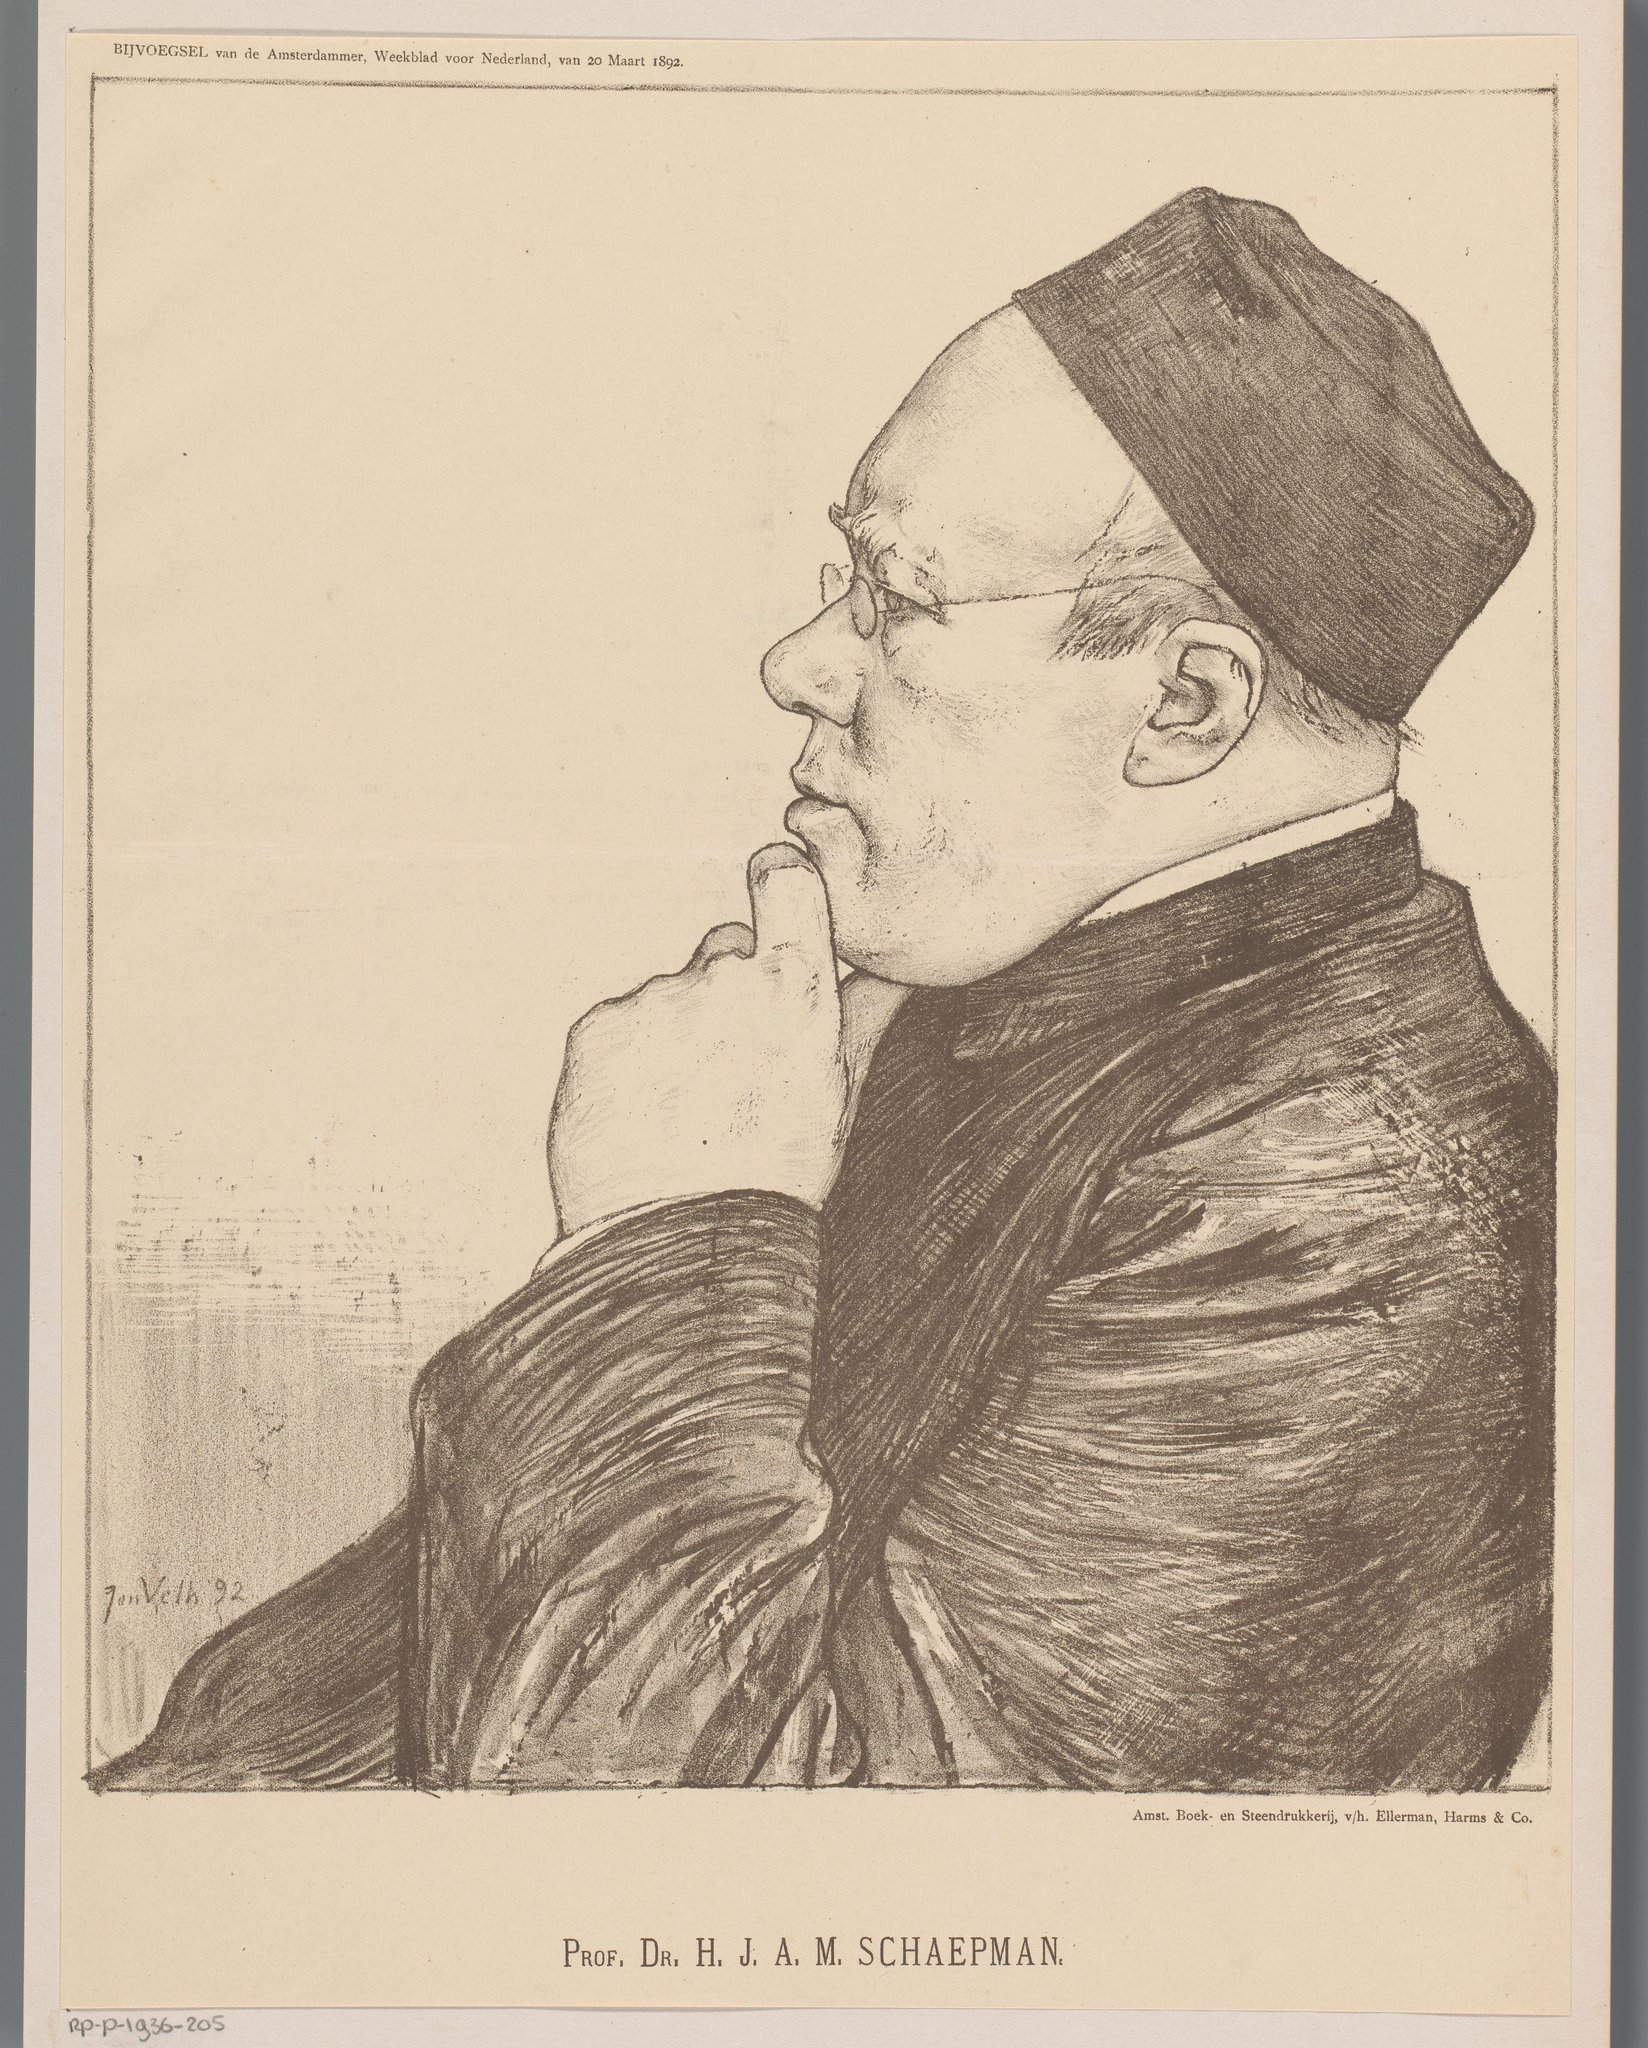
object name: print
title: Prof. Dr. H. J. A. M. Schaepman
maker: jan veth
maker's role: designer, draughtsman, painter, print maker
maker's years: 1864-1925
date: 1892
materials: paper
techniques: lithograph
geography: amsterdam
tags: rome, priest, herman johannes aloysius maria schaepman, theologian, historical persons, politician, e.g. party leader, writer, poet, author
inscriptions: collector's mark: Lugt 2228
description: Deze prent werd uitgegeven als bijvoegsel van De Amsterdammer op 20 maart 1892.